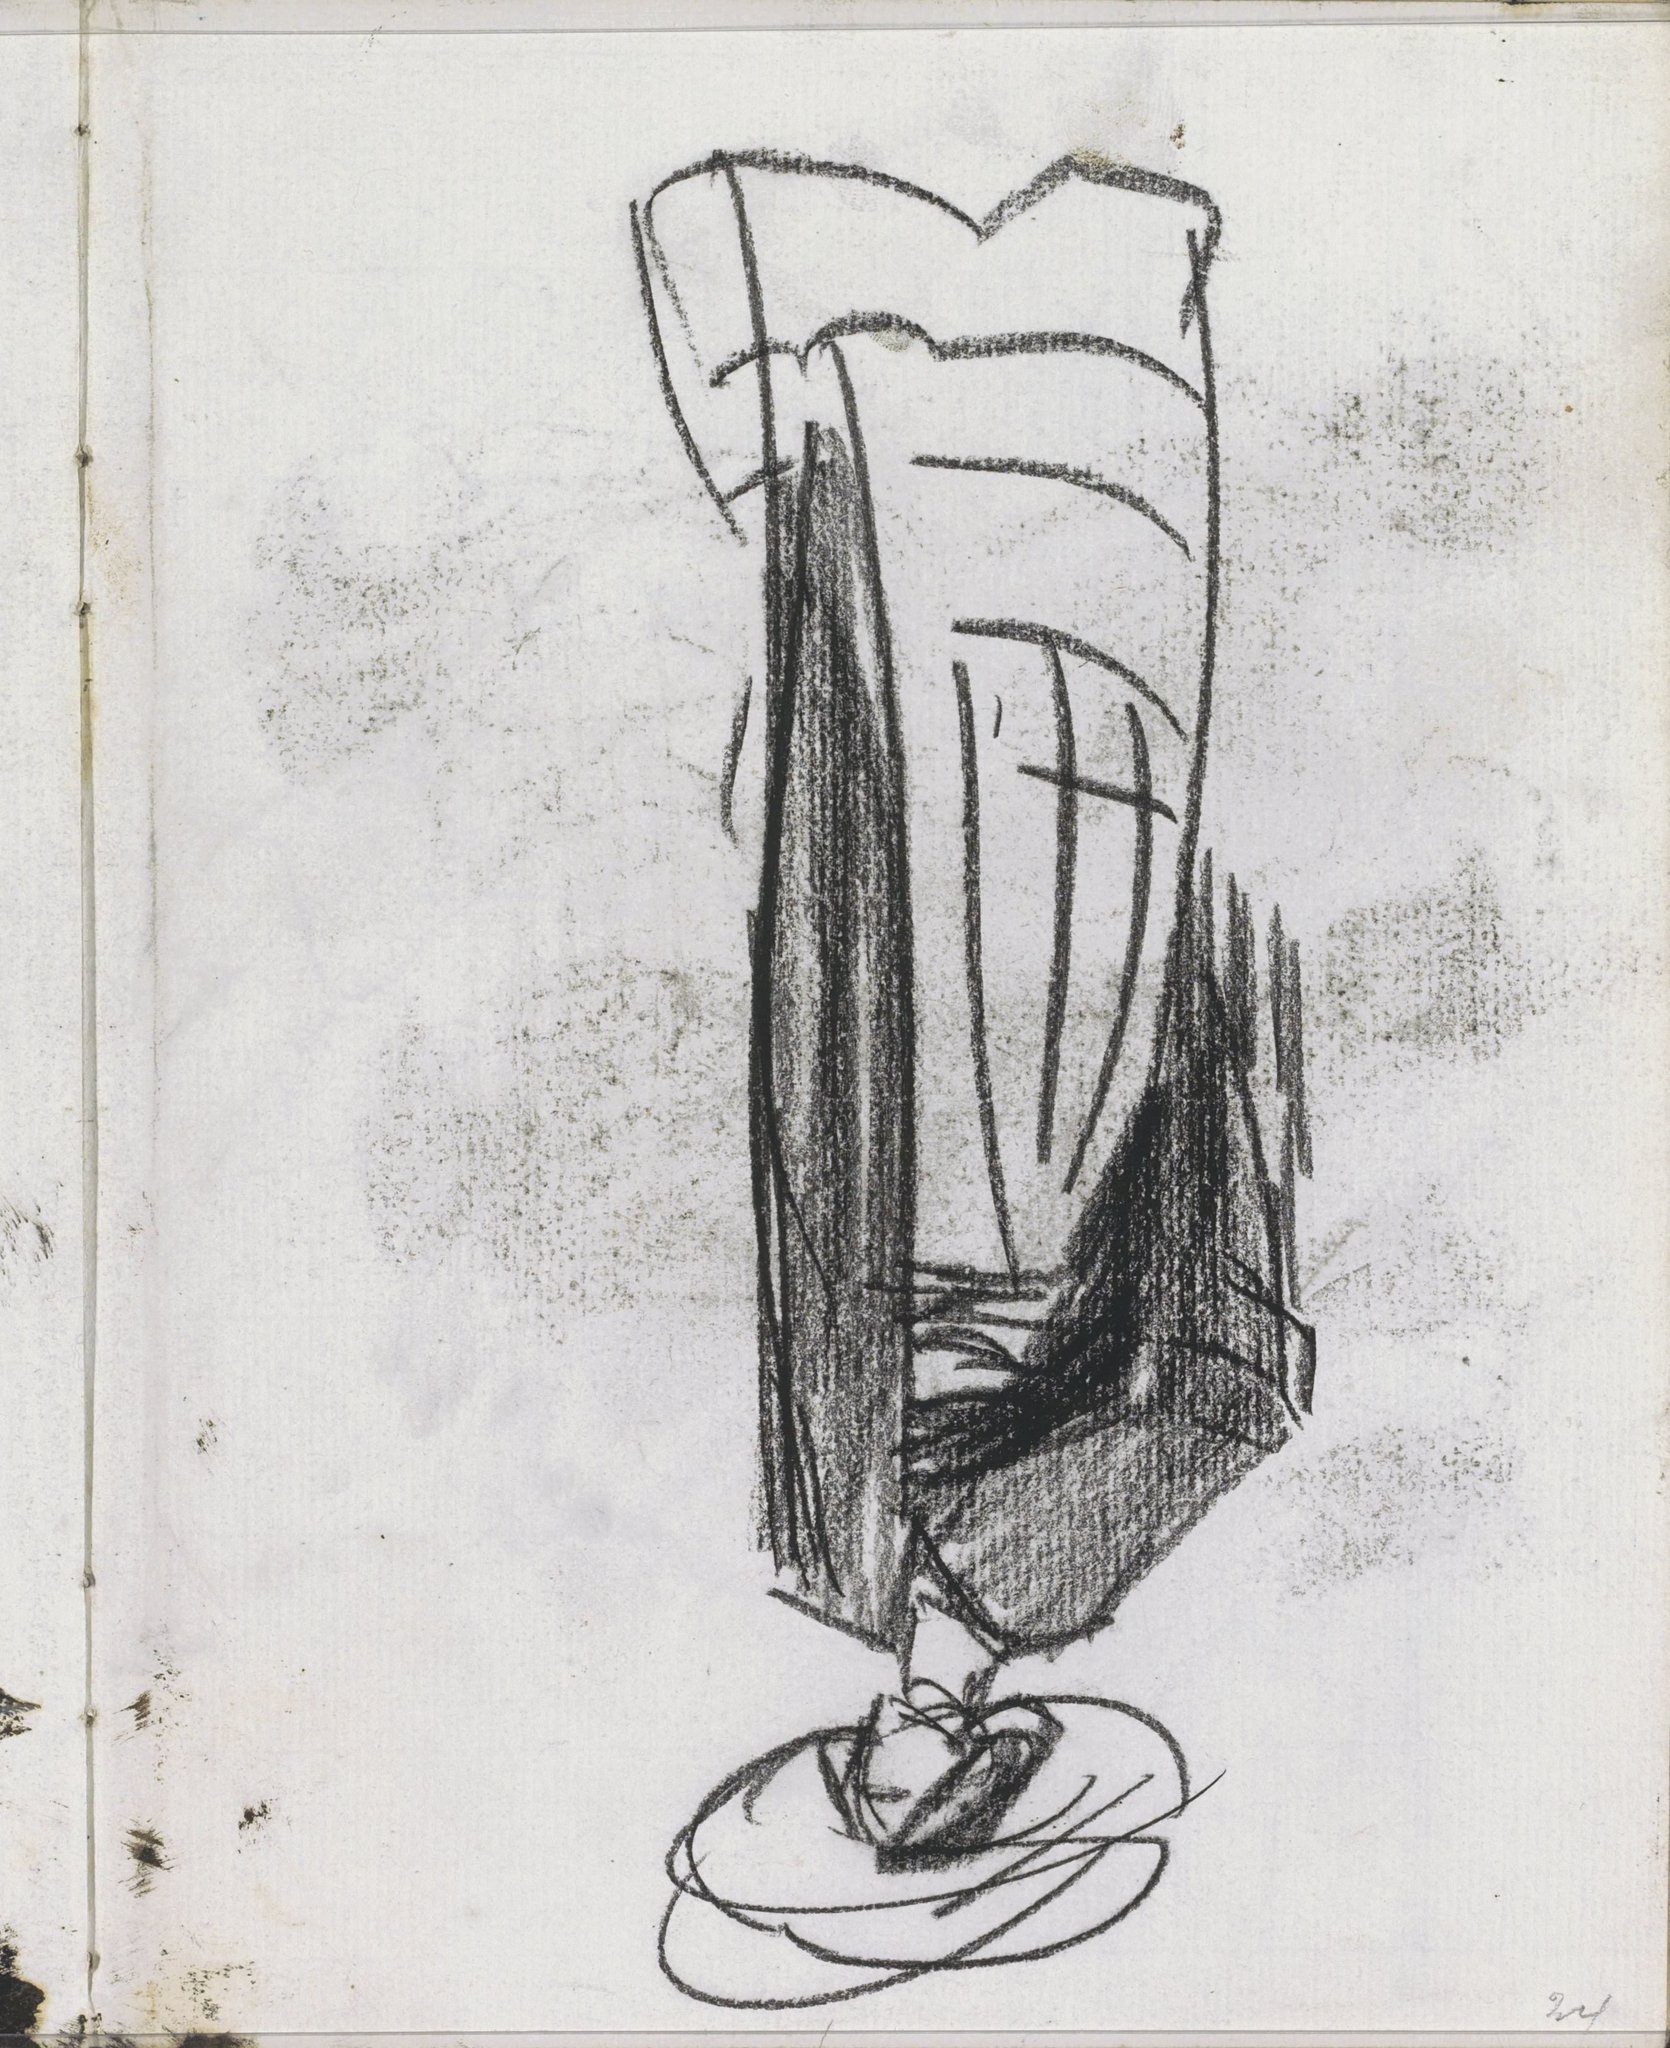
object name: sketchbook leaf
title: Staande vrouw met hoed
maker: isaac israels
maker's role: draughtsman, painter, print maker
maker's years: 1865-1934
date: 1875-1934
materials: chalk, paper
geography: the hague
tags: cape (+ women's clothes), head-gear: hat (+ women's clothes), adult woman (+ standing)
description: Ze draagt mogelijk een cape. Blad 24 recto uit schetsboek XIII met 25 bladen.